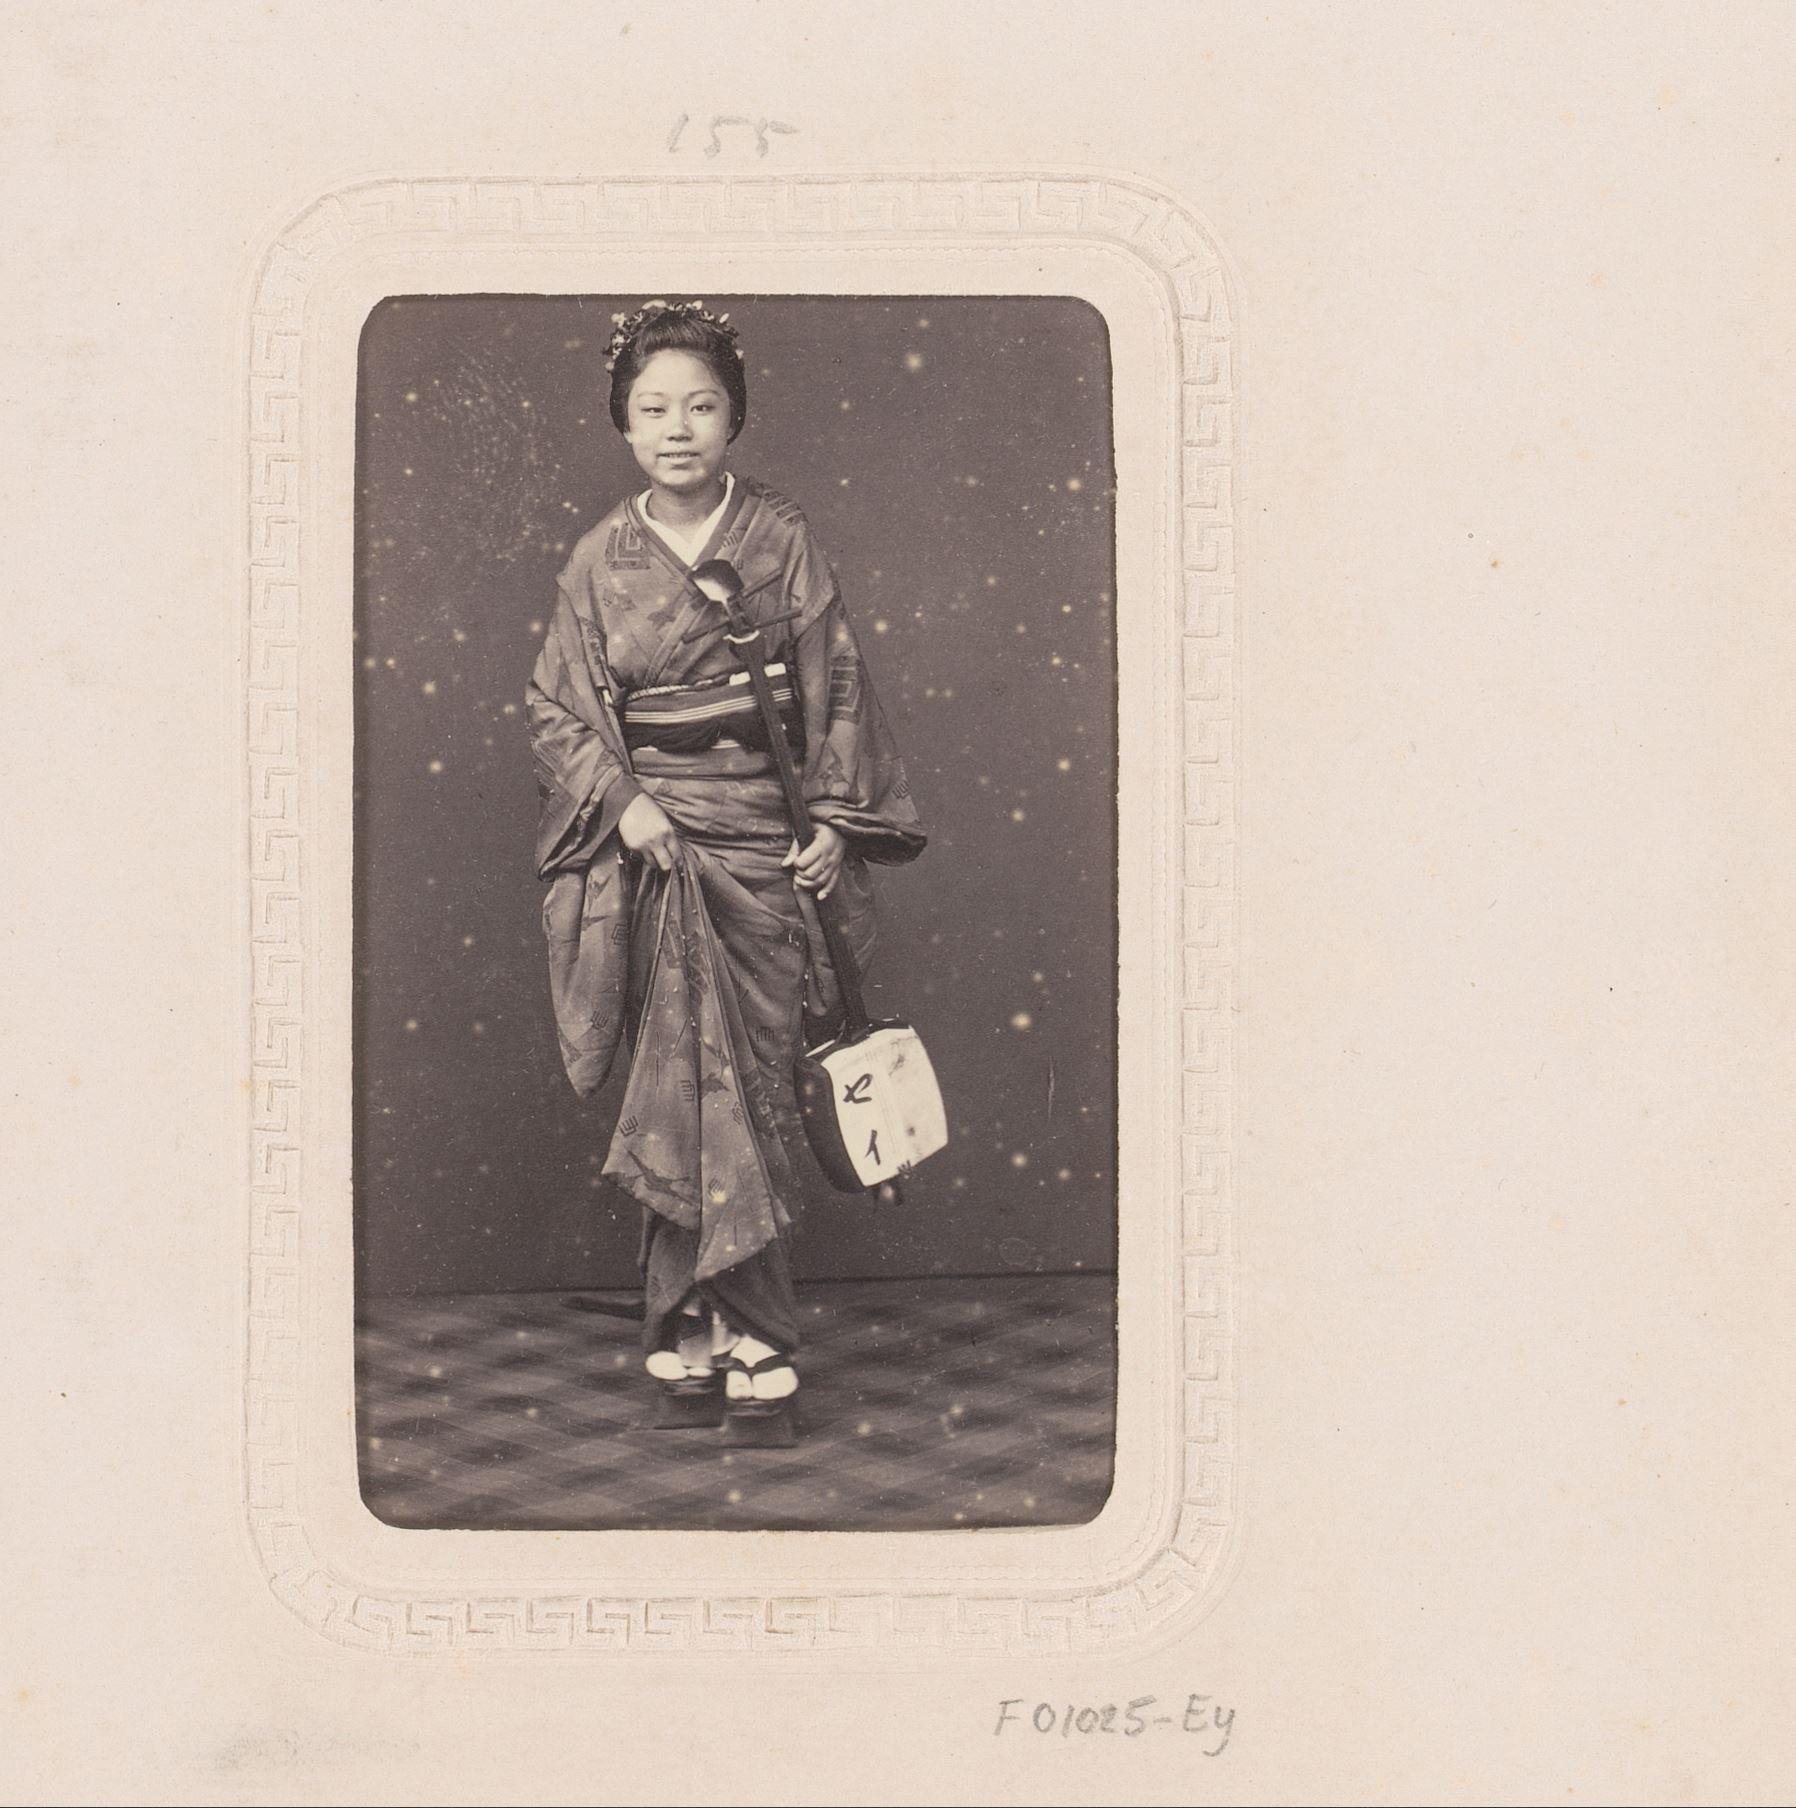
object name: album leaf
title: Portret van een Japans meisje met gitaar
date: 1857-1880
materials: cardboard, photographic support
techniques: albumen print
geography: java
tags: historical persons - bb - woman, cithern, mandolin, guitar, balalaika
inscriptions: inscription: ‘Woodbury & Page/ Photographers/ Java’, number: ‘155’